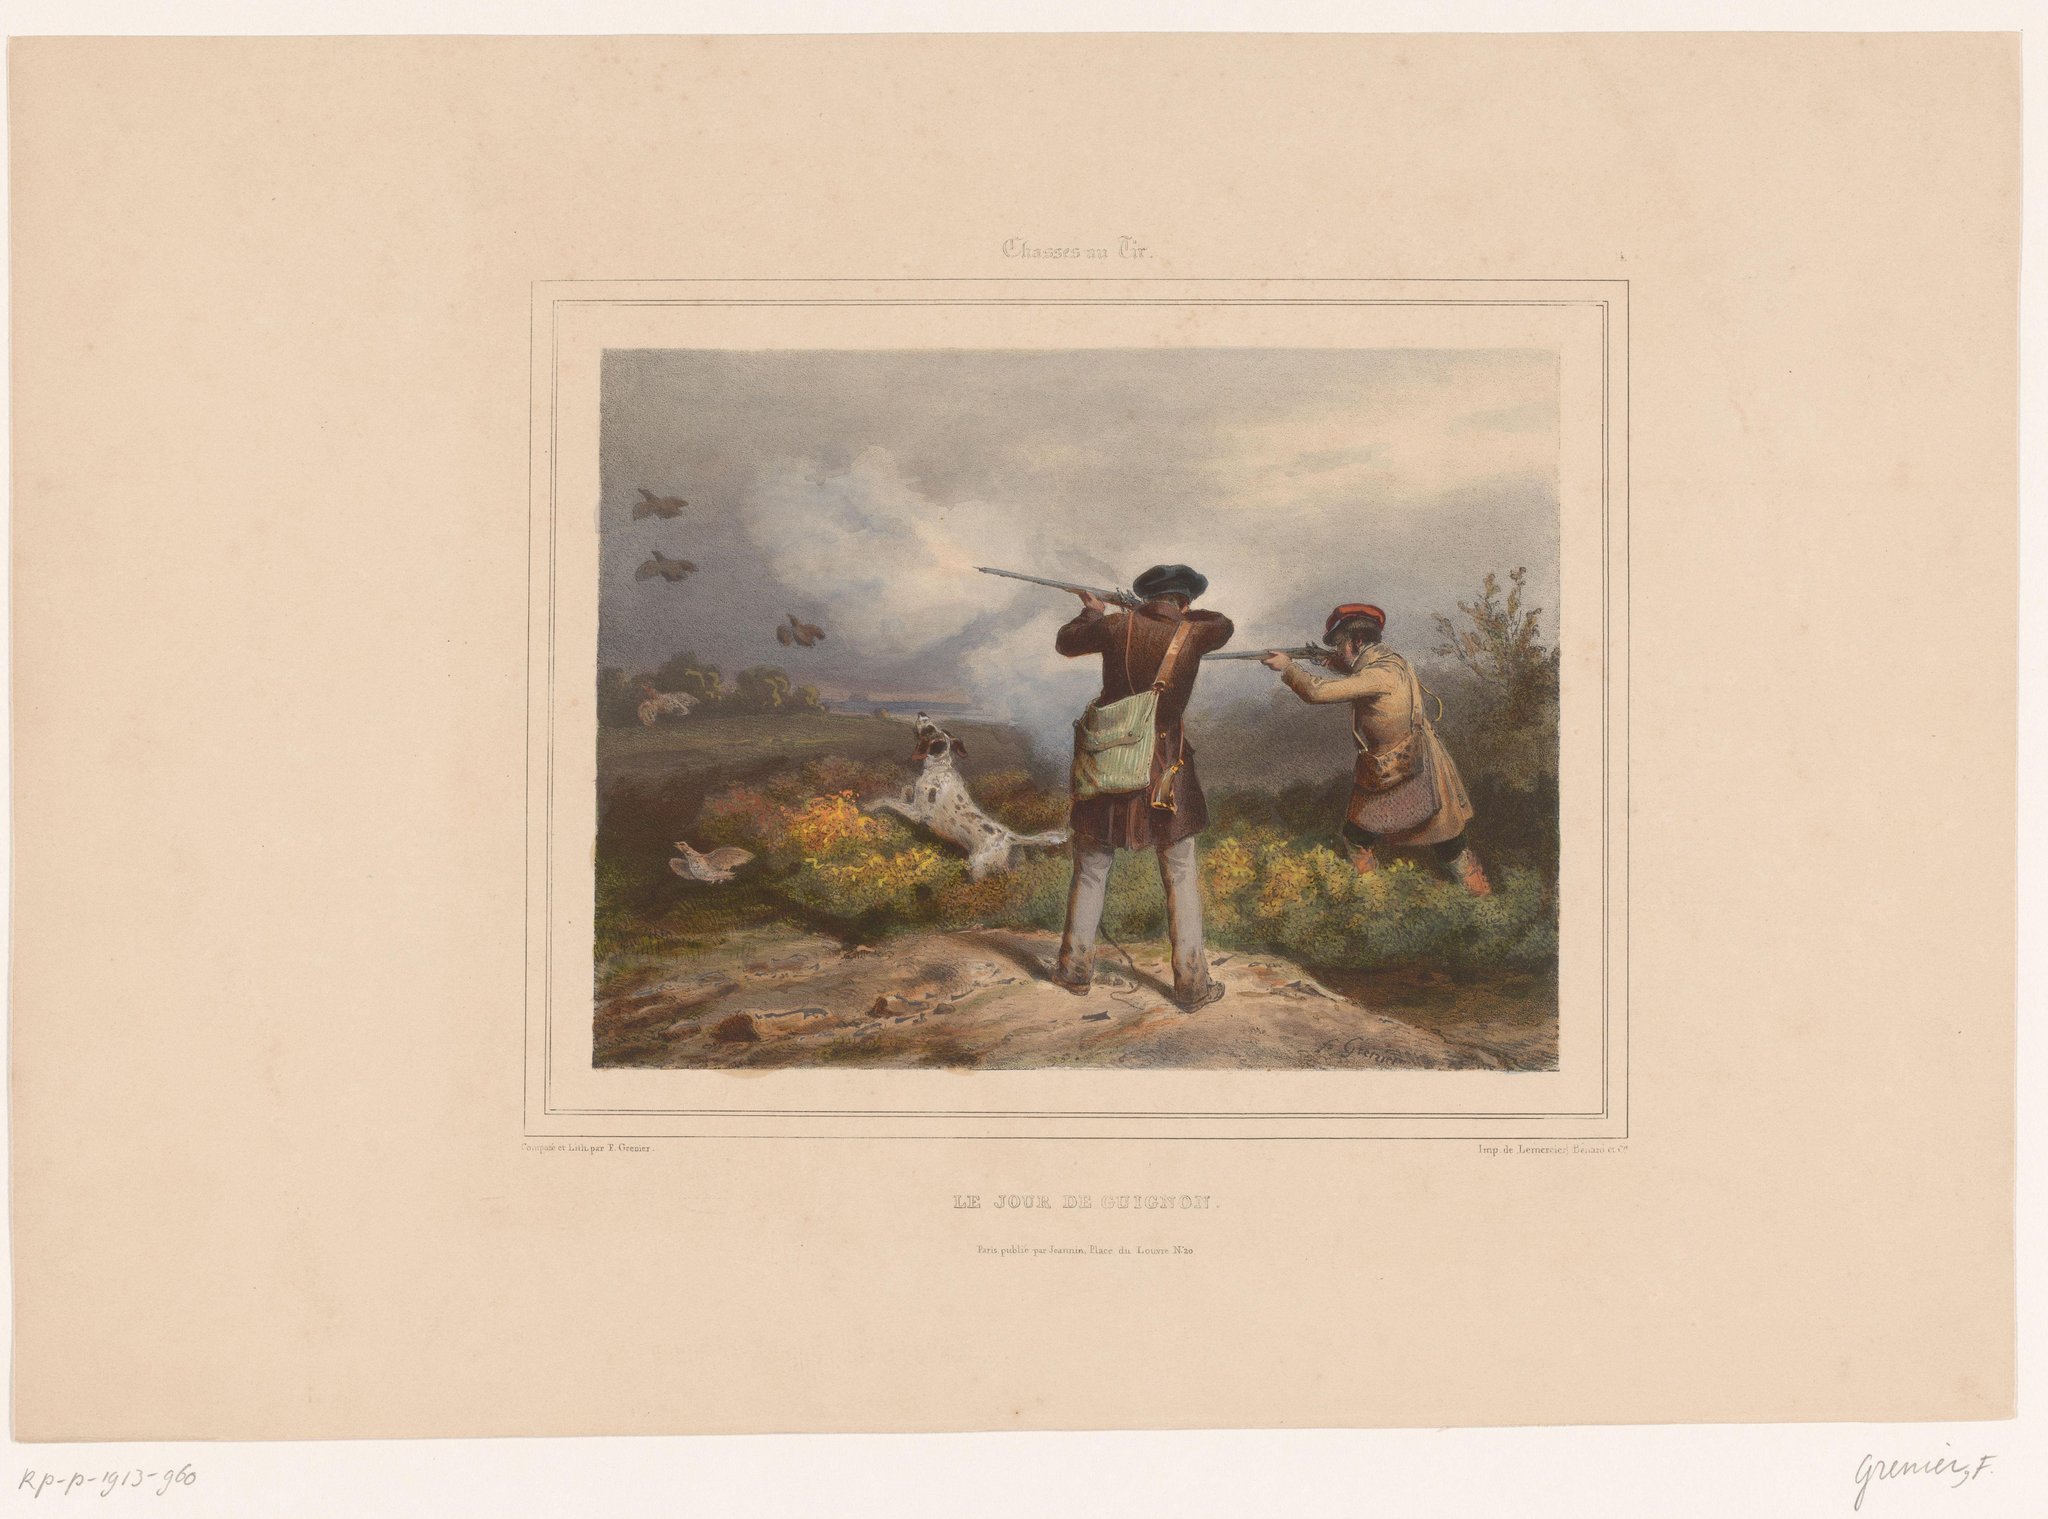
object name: print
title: Le jour de guignon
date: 1831-1846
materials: paper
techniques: hand coloring, lithograph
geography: paris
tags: hunter, bird hunting, firearms: rifle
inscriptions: collector's mark: Lugt 2228a, check stamp: Lugt 1397c